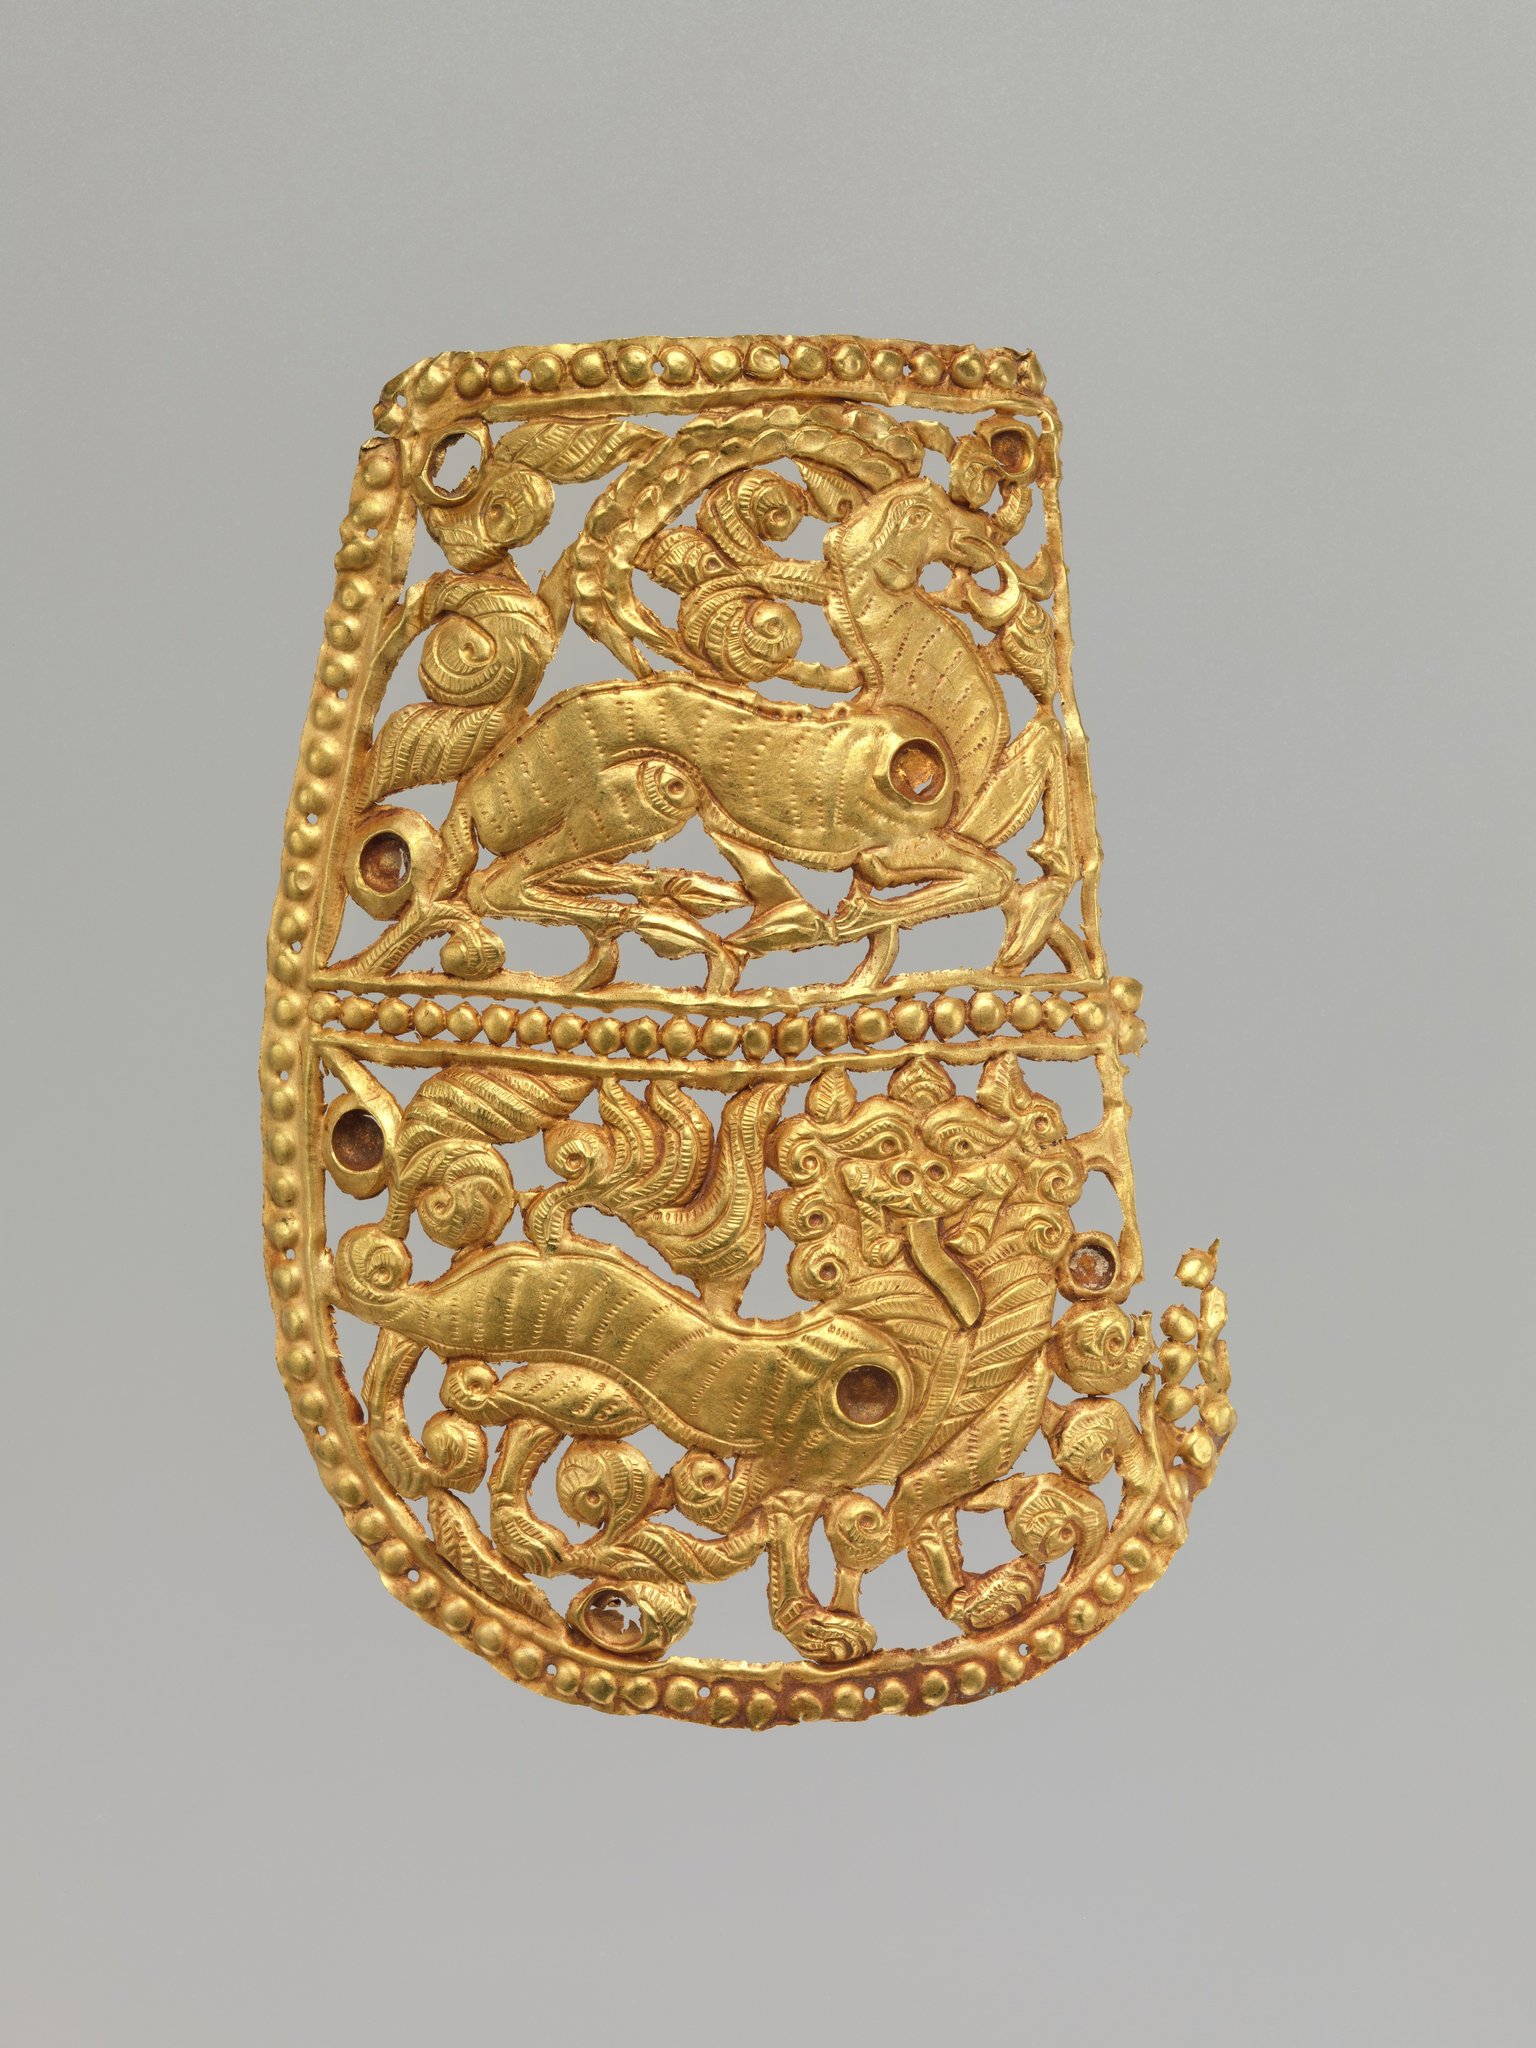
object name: garment plaque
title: Clothing Plaque with Antelope and Tiger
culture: chinese or central asian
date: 601-900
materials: gold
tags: tigers